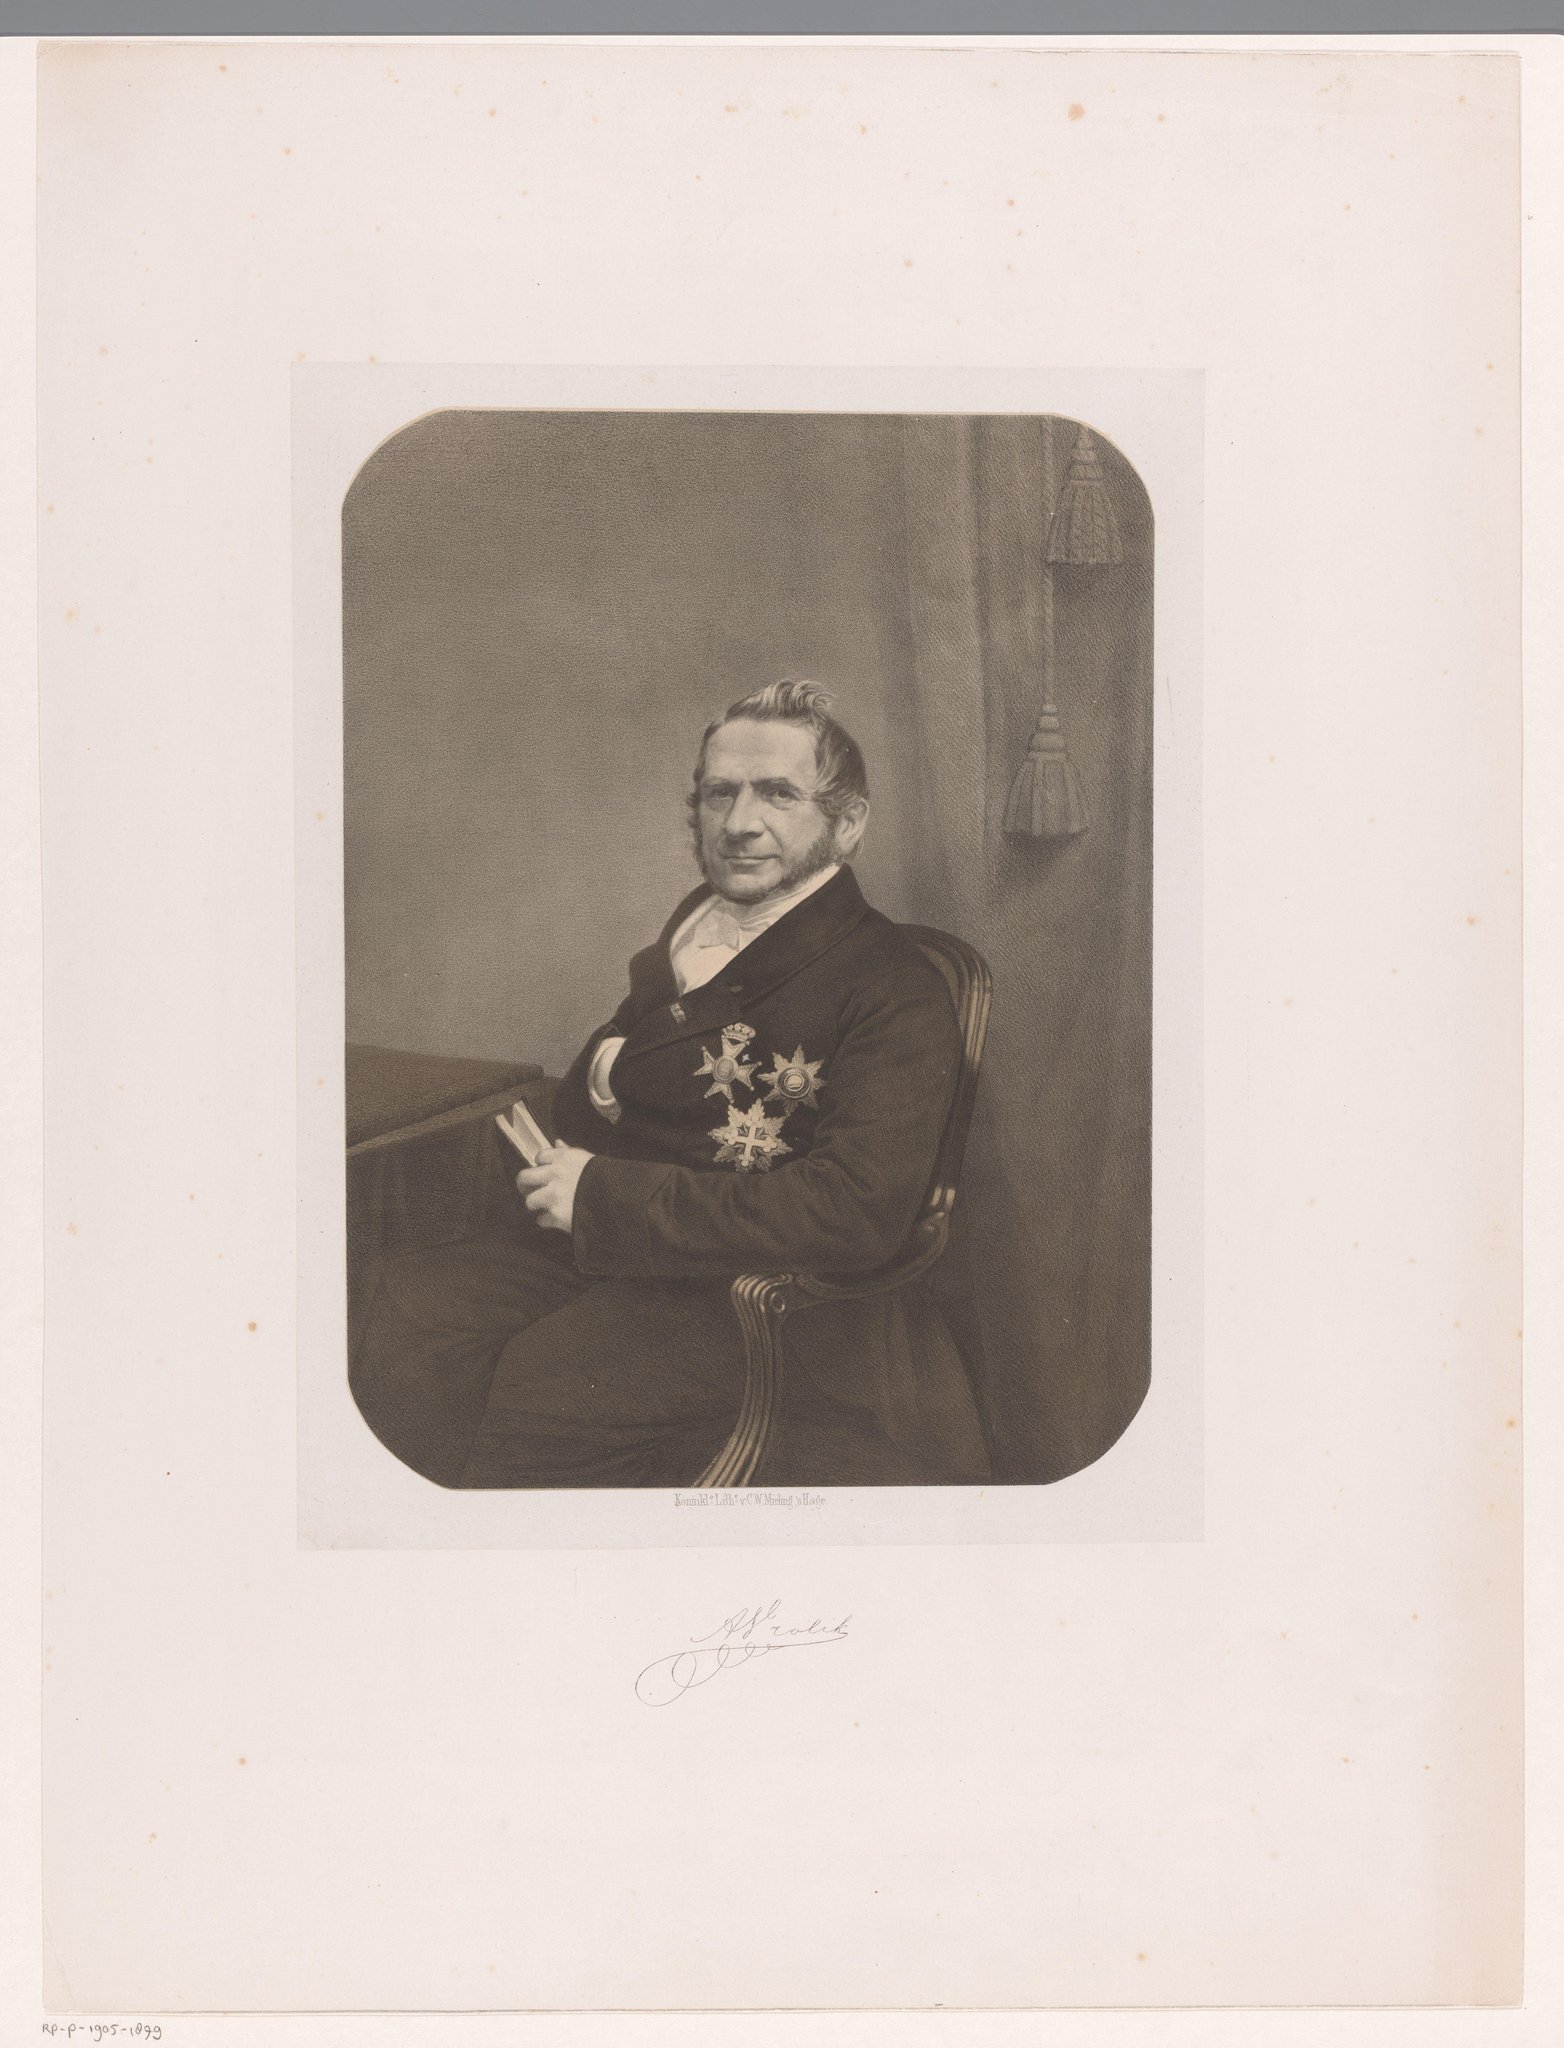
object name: print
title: Portret van Agnites Vrolik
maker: Anonymous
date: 1847-1865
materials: paper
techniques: lithograph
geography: the hague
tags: amsterdam, agnites vrolik, knighthood order, book, historical persons (+ half-length portrait)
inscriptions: collector's mark: Lugt 2228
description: De geportretteerde zit aan een tafel met een boek in zijn linkerhand. Zijn rechterhand heeft hij in zijn jas gestoken. Op zijn jas twee ridderorden een grootkruis en een erelint. Onder het portret zijn signatuur.